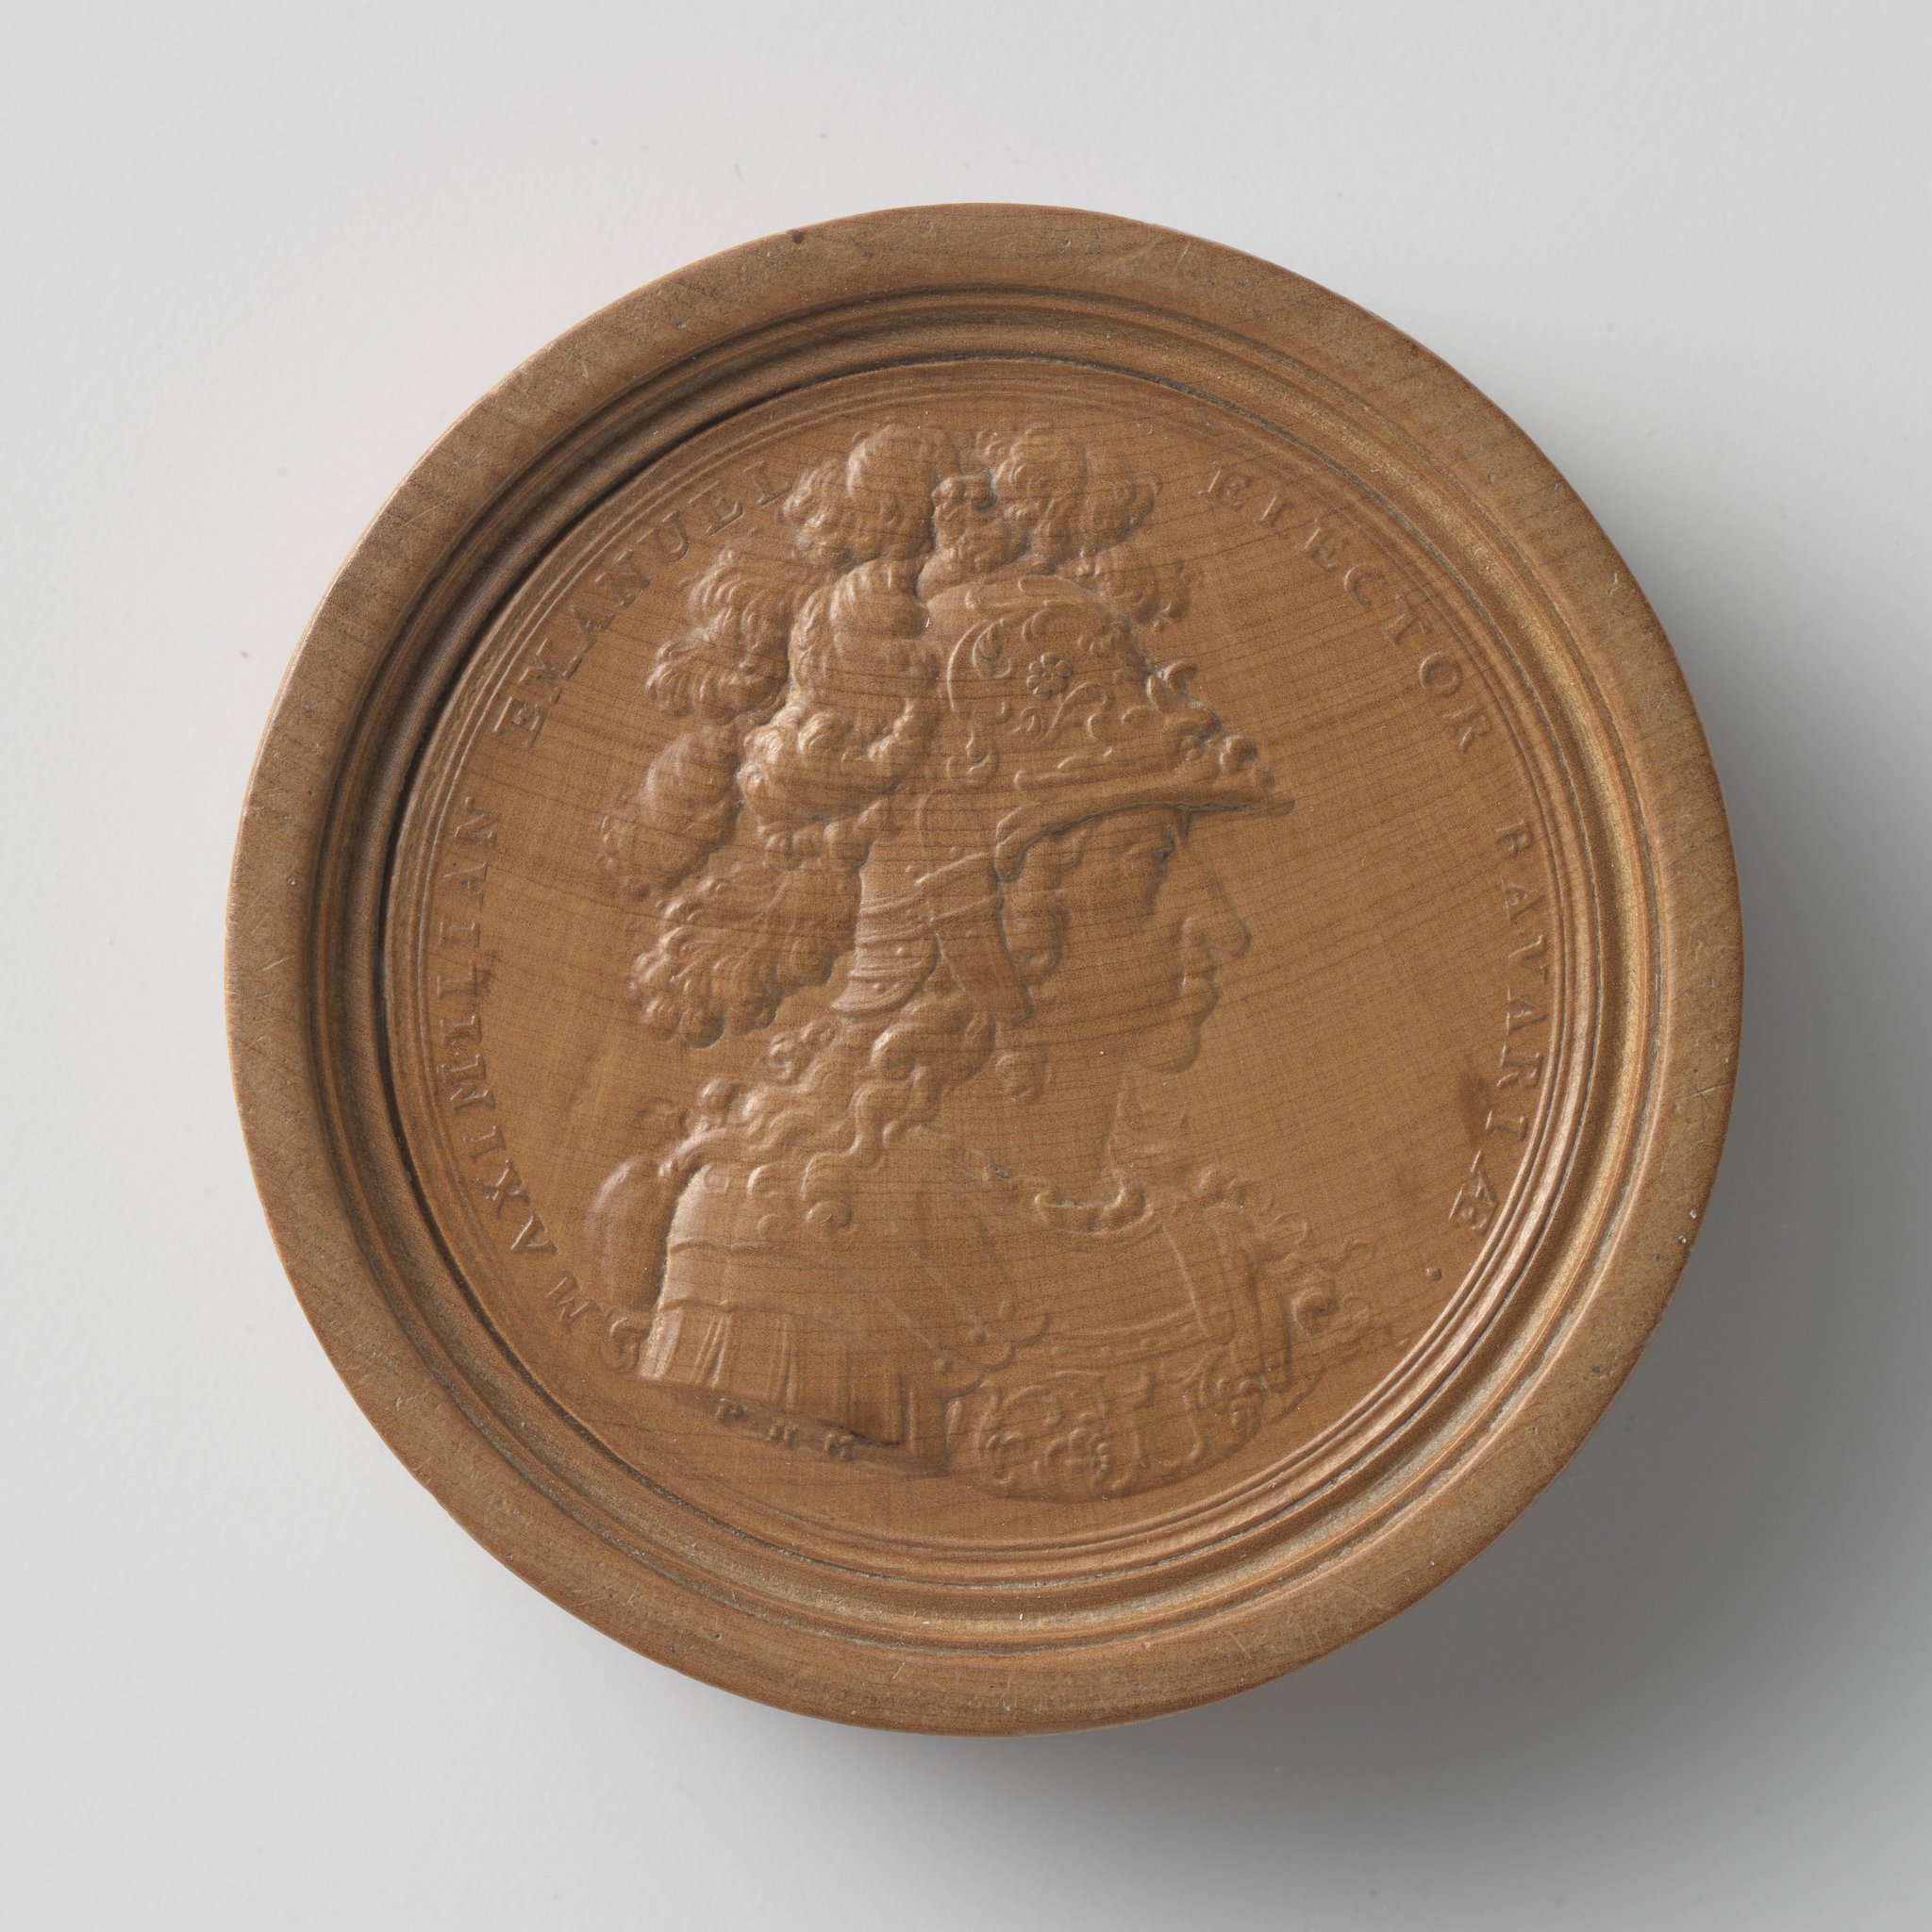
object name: sculpture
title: Damschijf met voorstelling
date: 1675-1700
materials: wood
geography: germany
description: Opschrift langs de bovenrand 'QUI ME VIVENTE LACESSAS PERITHOUM VIOLASQUE DUOS', onderaan 'THESEUS BAVARICUS 1689. Afbeelding van een soldaat in gevecht met een centaur. Op de achterkant 'MAXIMILIAN EMANUEL ELECTOR BAVARIAE, langs de armafsnijding getekend P.H.M., een portret.